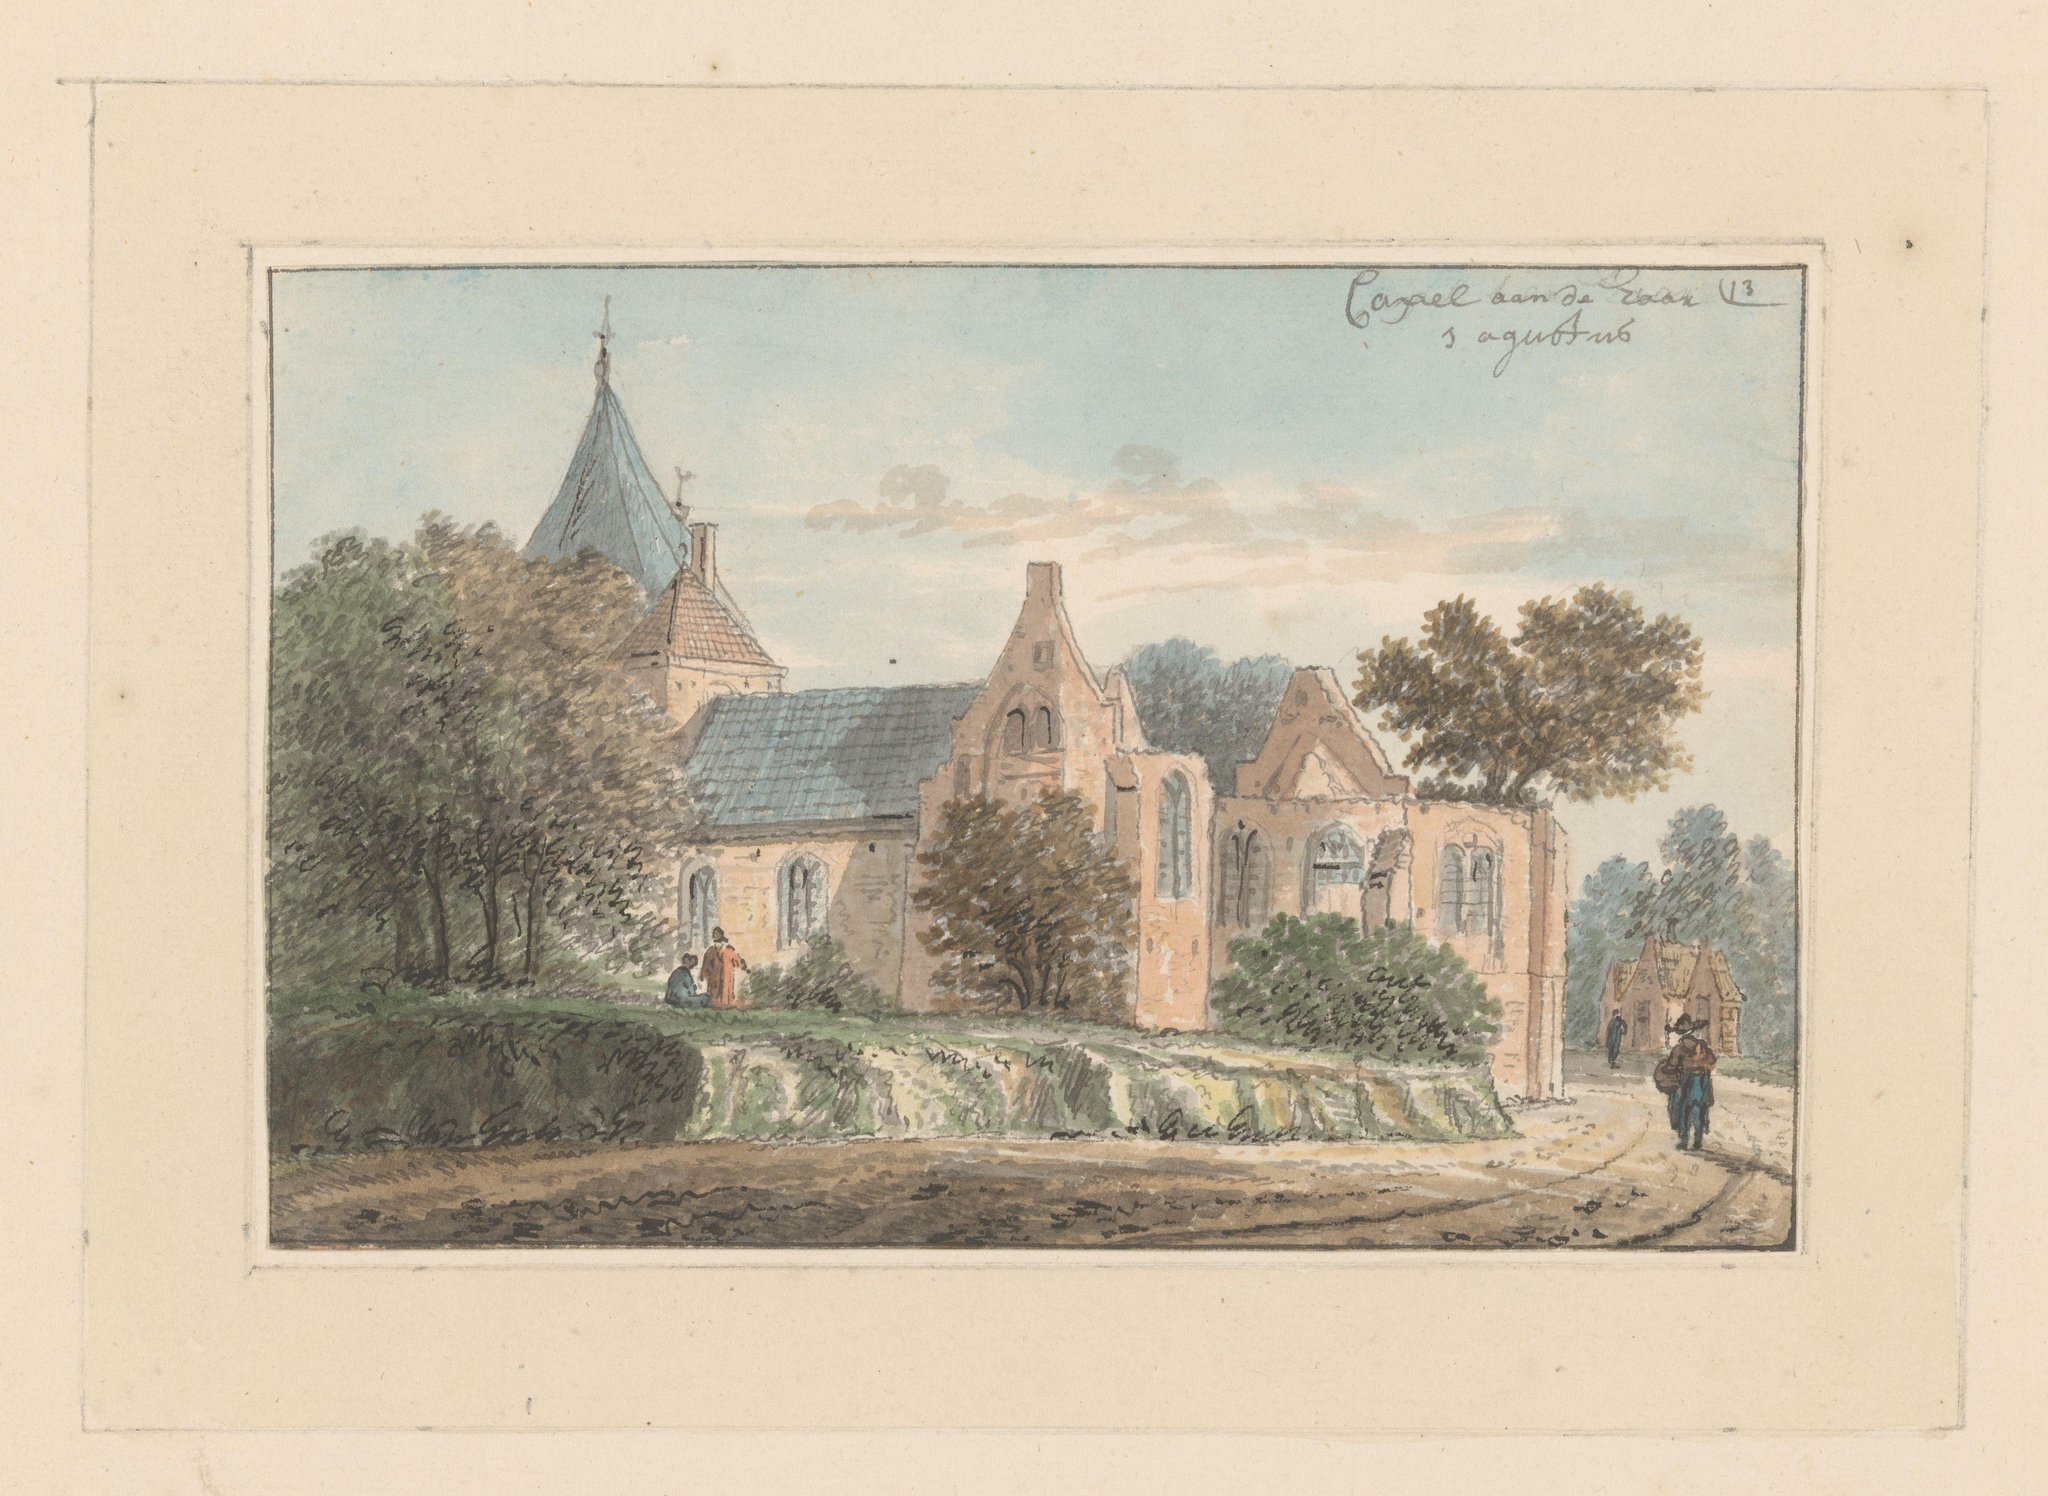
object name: drawing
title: Gezicht op de kapel bij kasteel De Haar in Haarzuilens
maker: Anonymous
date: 1700-1799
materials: ink, paper, watercolor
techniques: aquarelle, drawing, pen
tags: castle, landscape with tower or castle